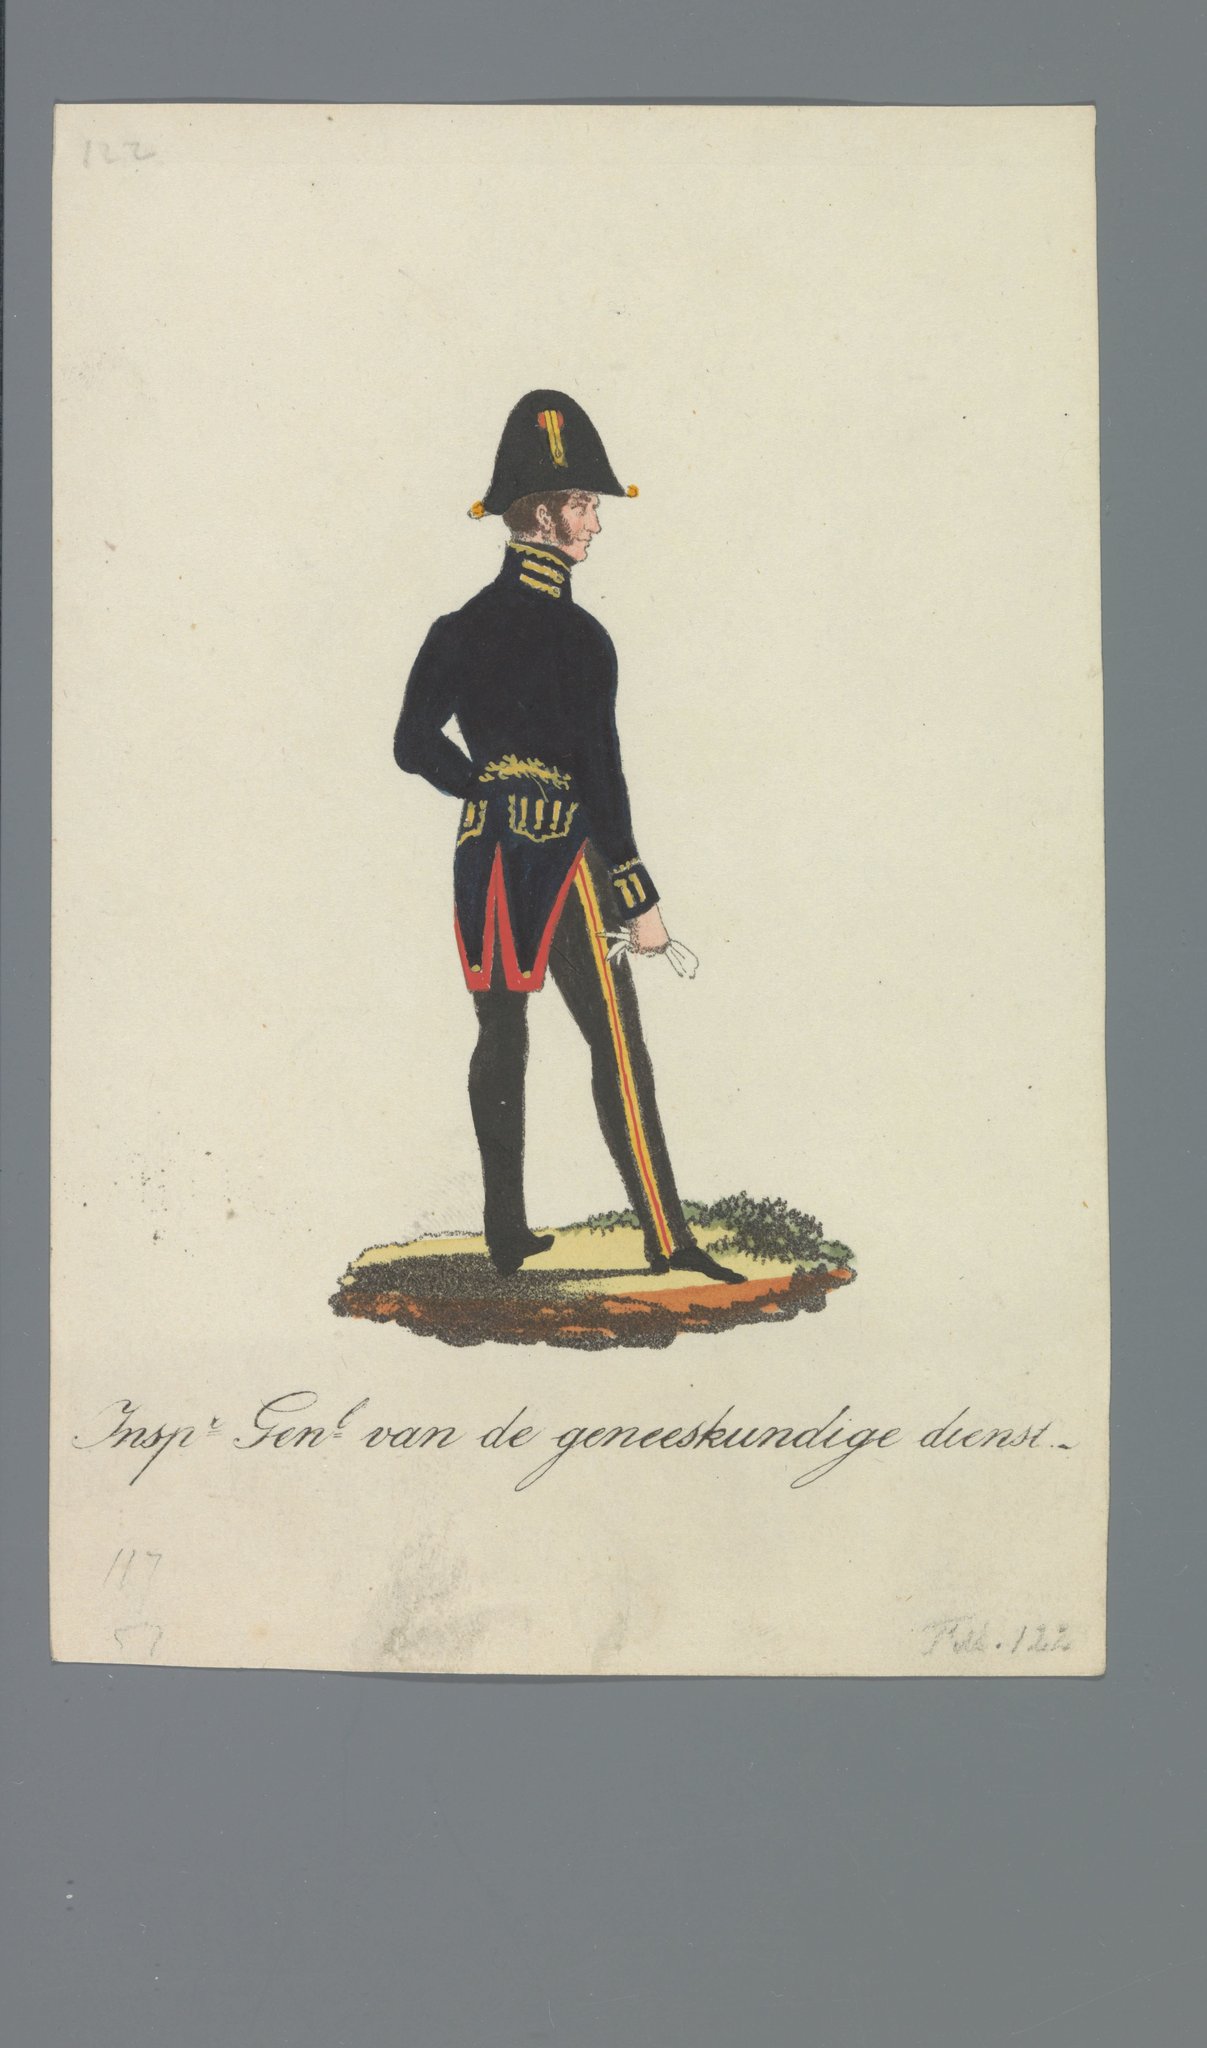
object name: print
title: Insp.r Gen.l van de geneeskundige dienst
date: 1835-1850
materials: paper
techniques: hand coloring, lithograph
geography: utrecht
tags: (military) uniforms, clothes, costume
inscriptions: collector's mark: Lugt 2228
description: Een inspecteur-generaal van de geneeskundige dienst, te voet. Onderdeel van een serie van 157 losse bladen met Nederlandse militaire uniformen in de jaren 1830-1832.